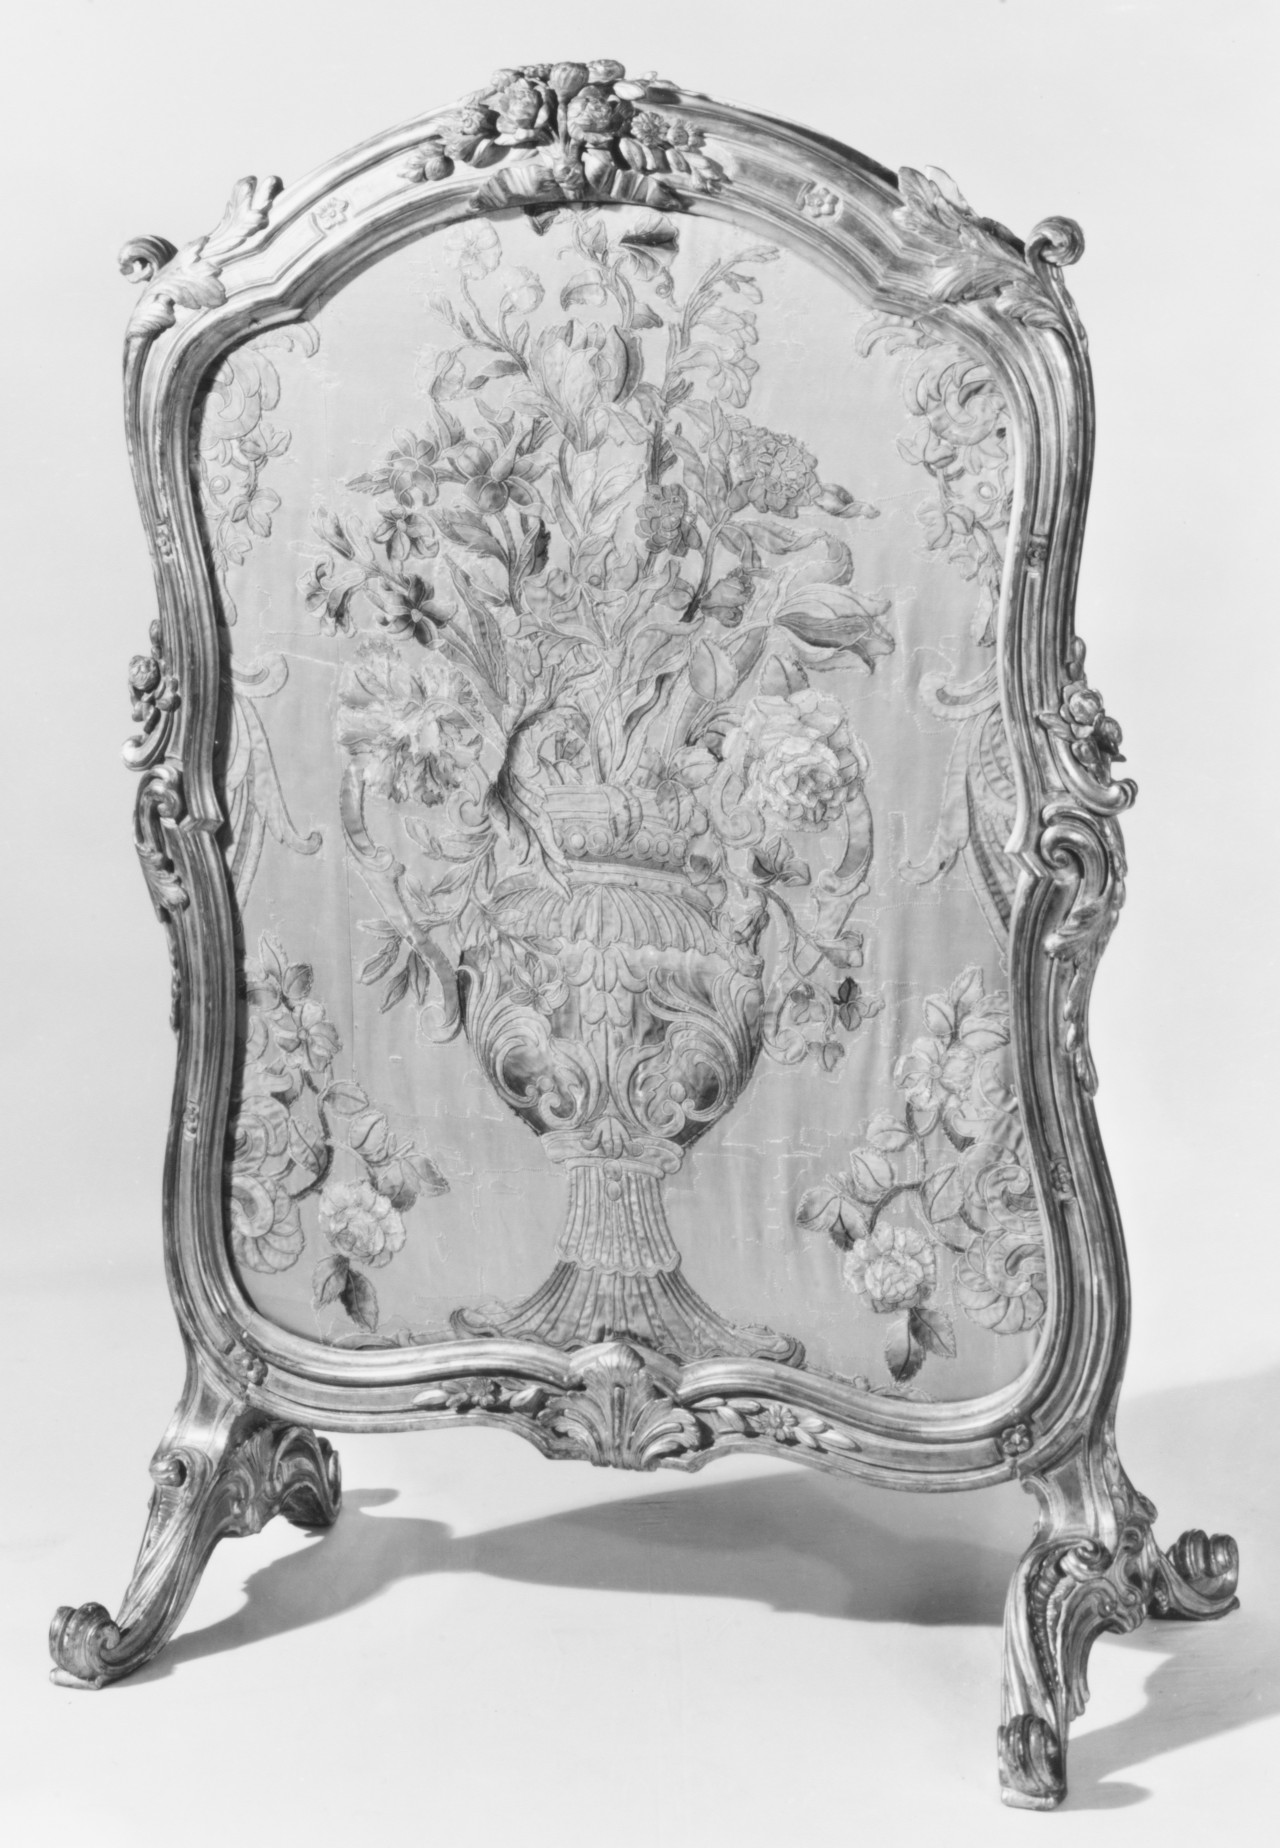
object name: fire screen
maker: jean-baptiste i tilliard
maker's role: maker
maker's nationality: french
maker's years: 1686-1766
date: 1750-1760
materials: wood, silk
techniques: carving, embroidery, gilding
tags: flowers